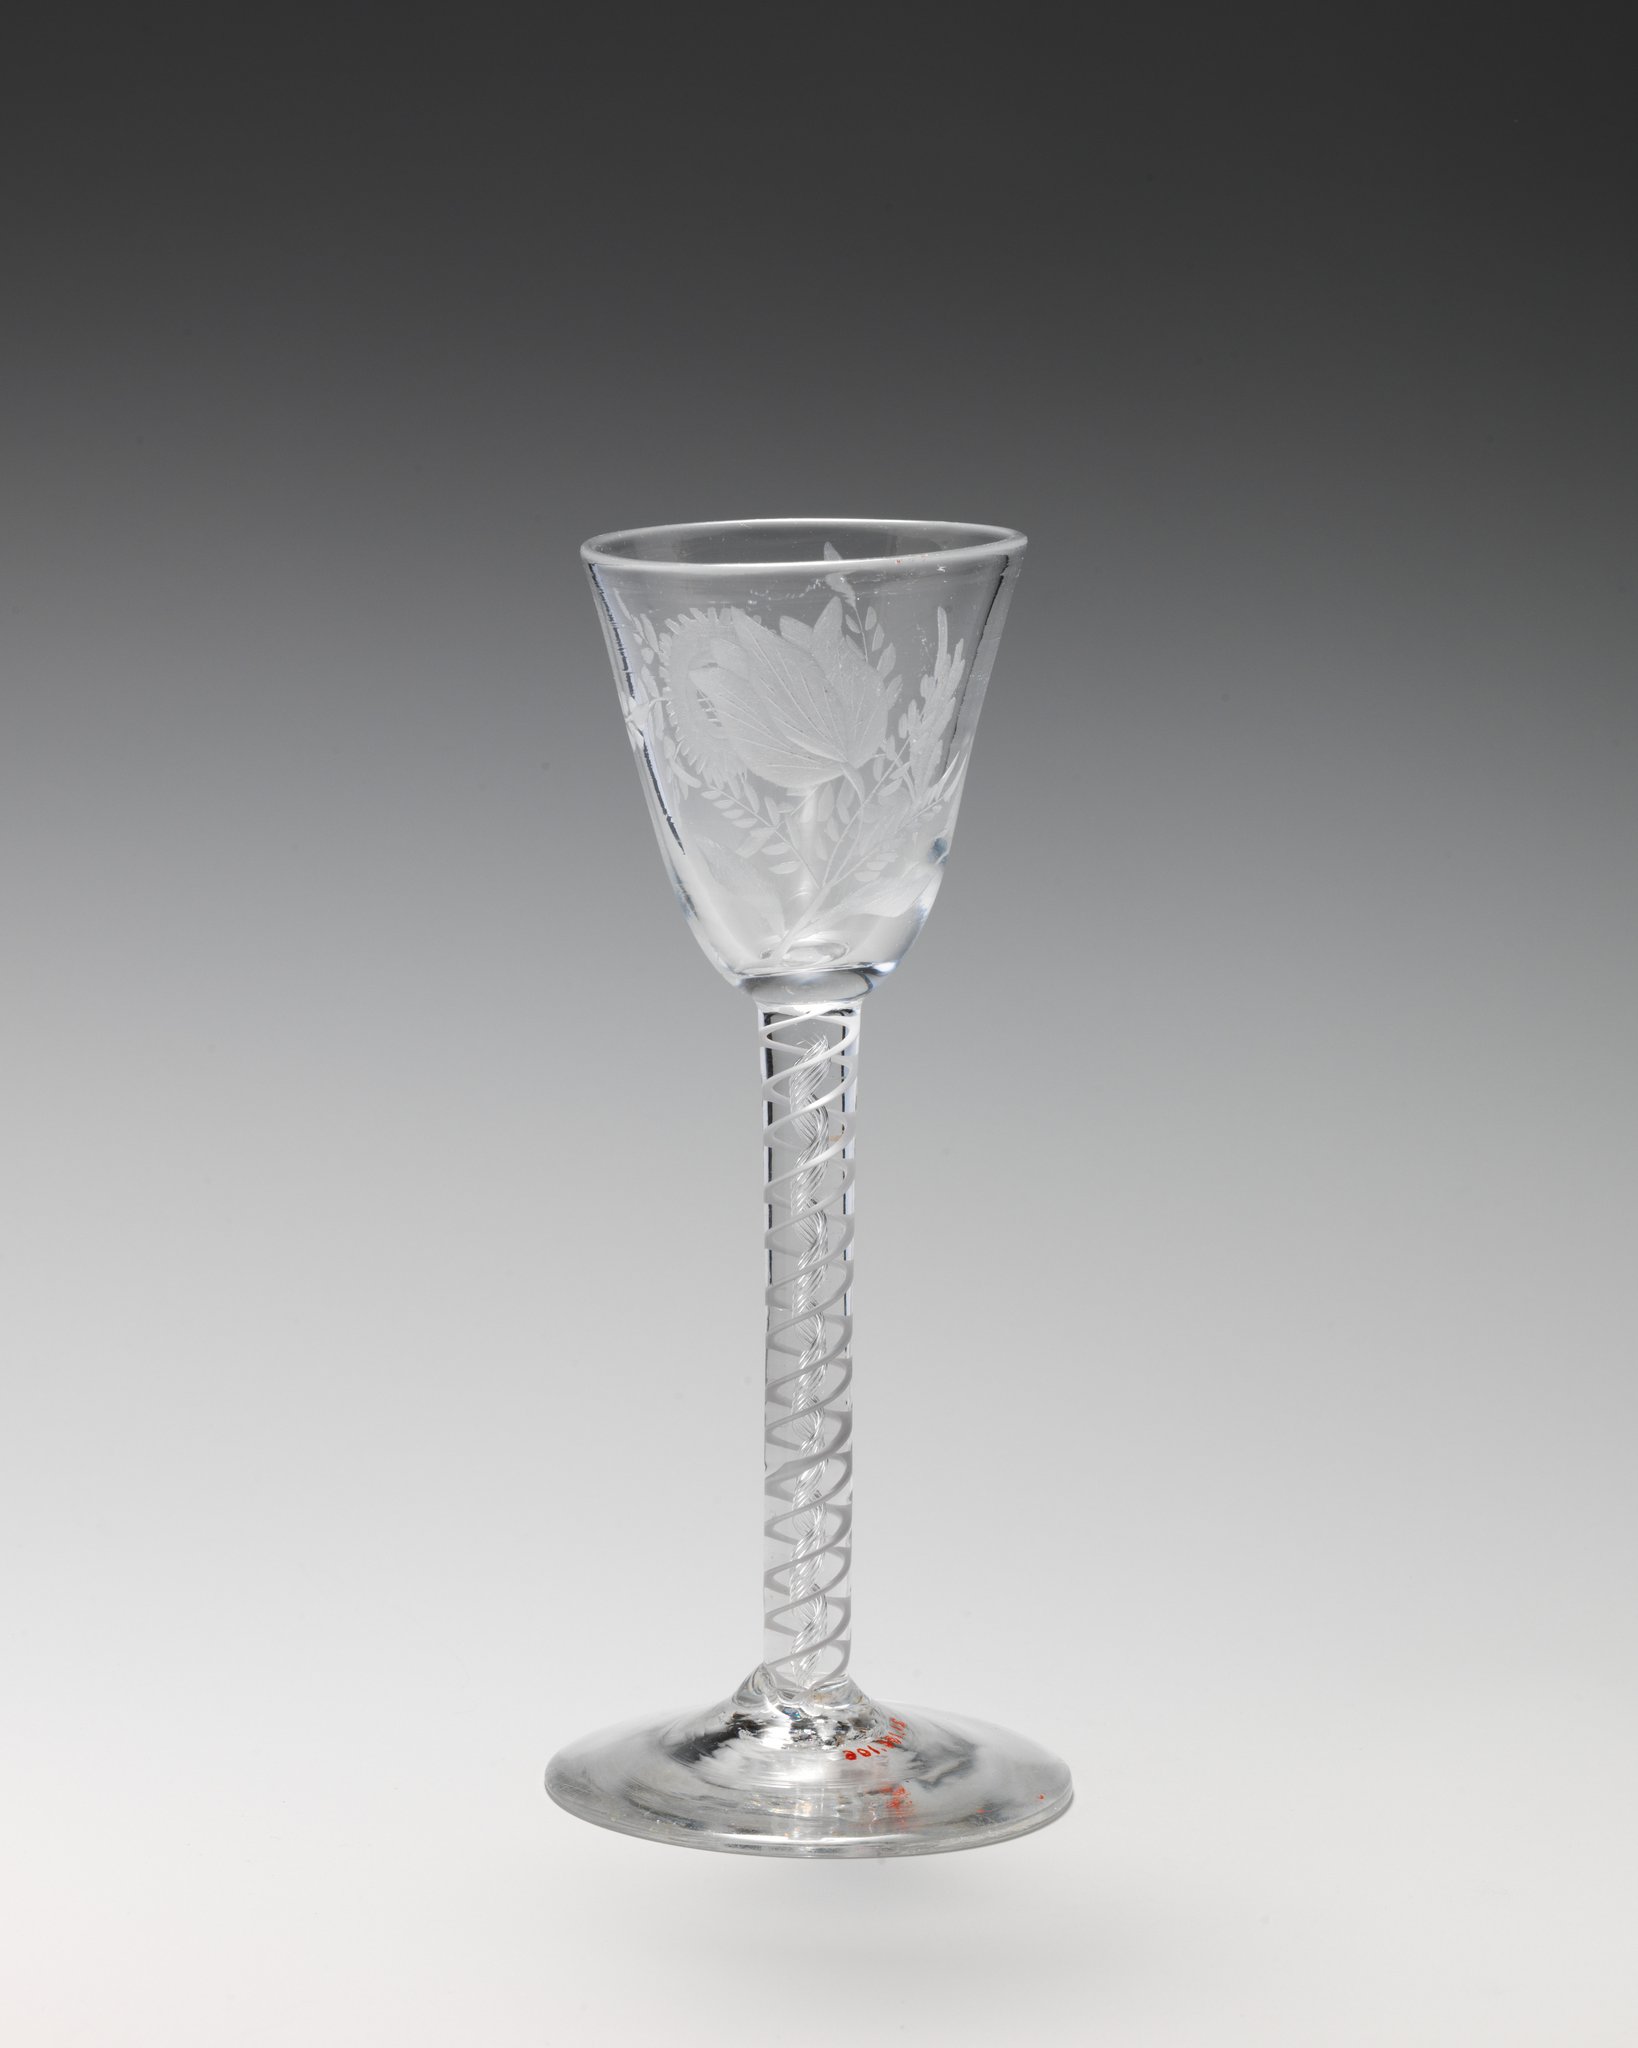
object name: wineglass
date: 1780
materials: glass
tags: flowers